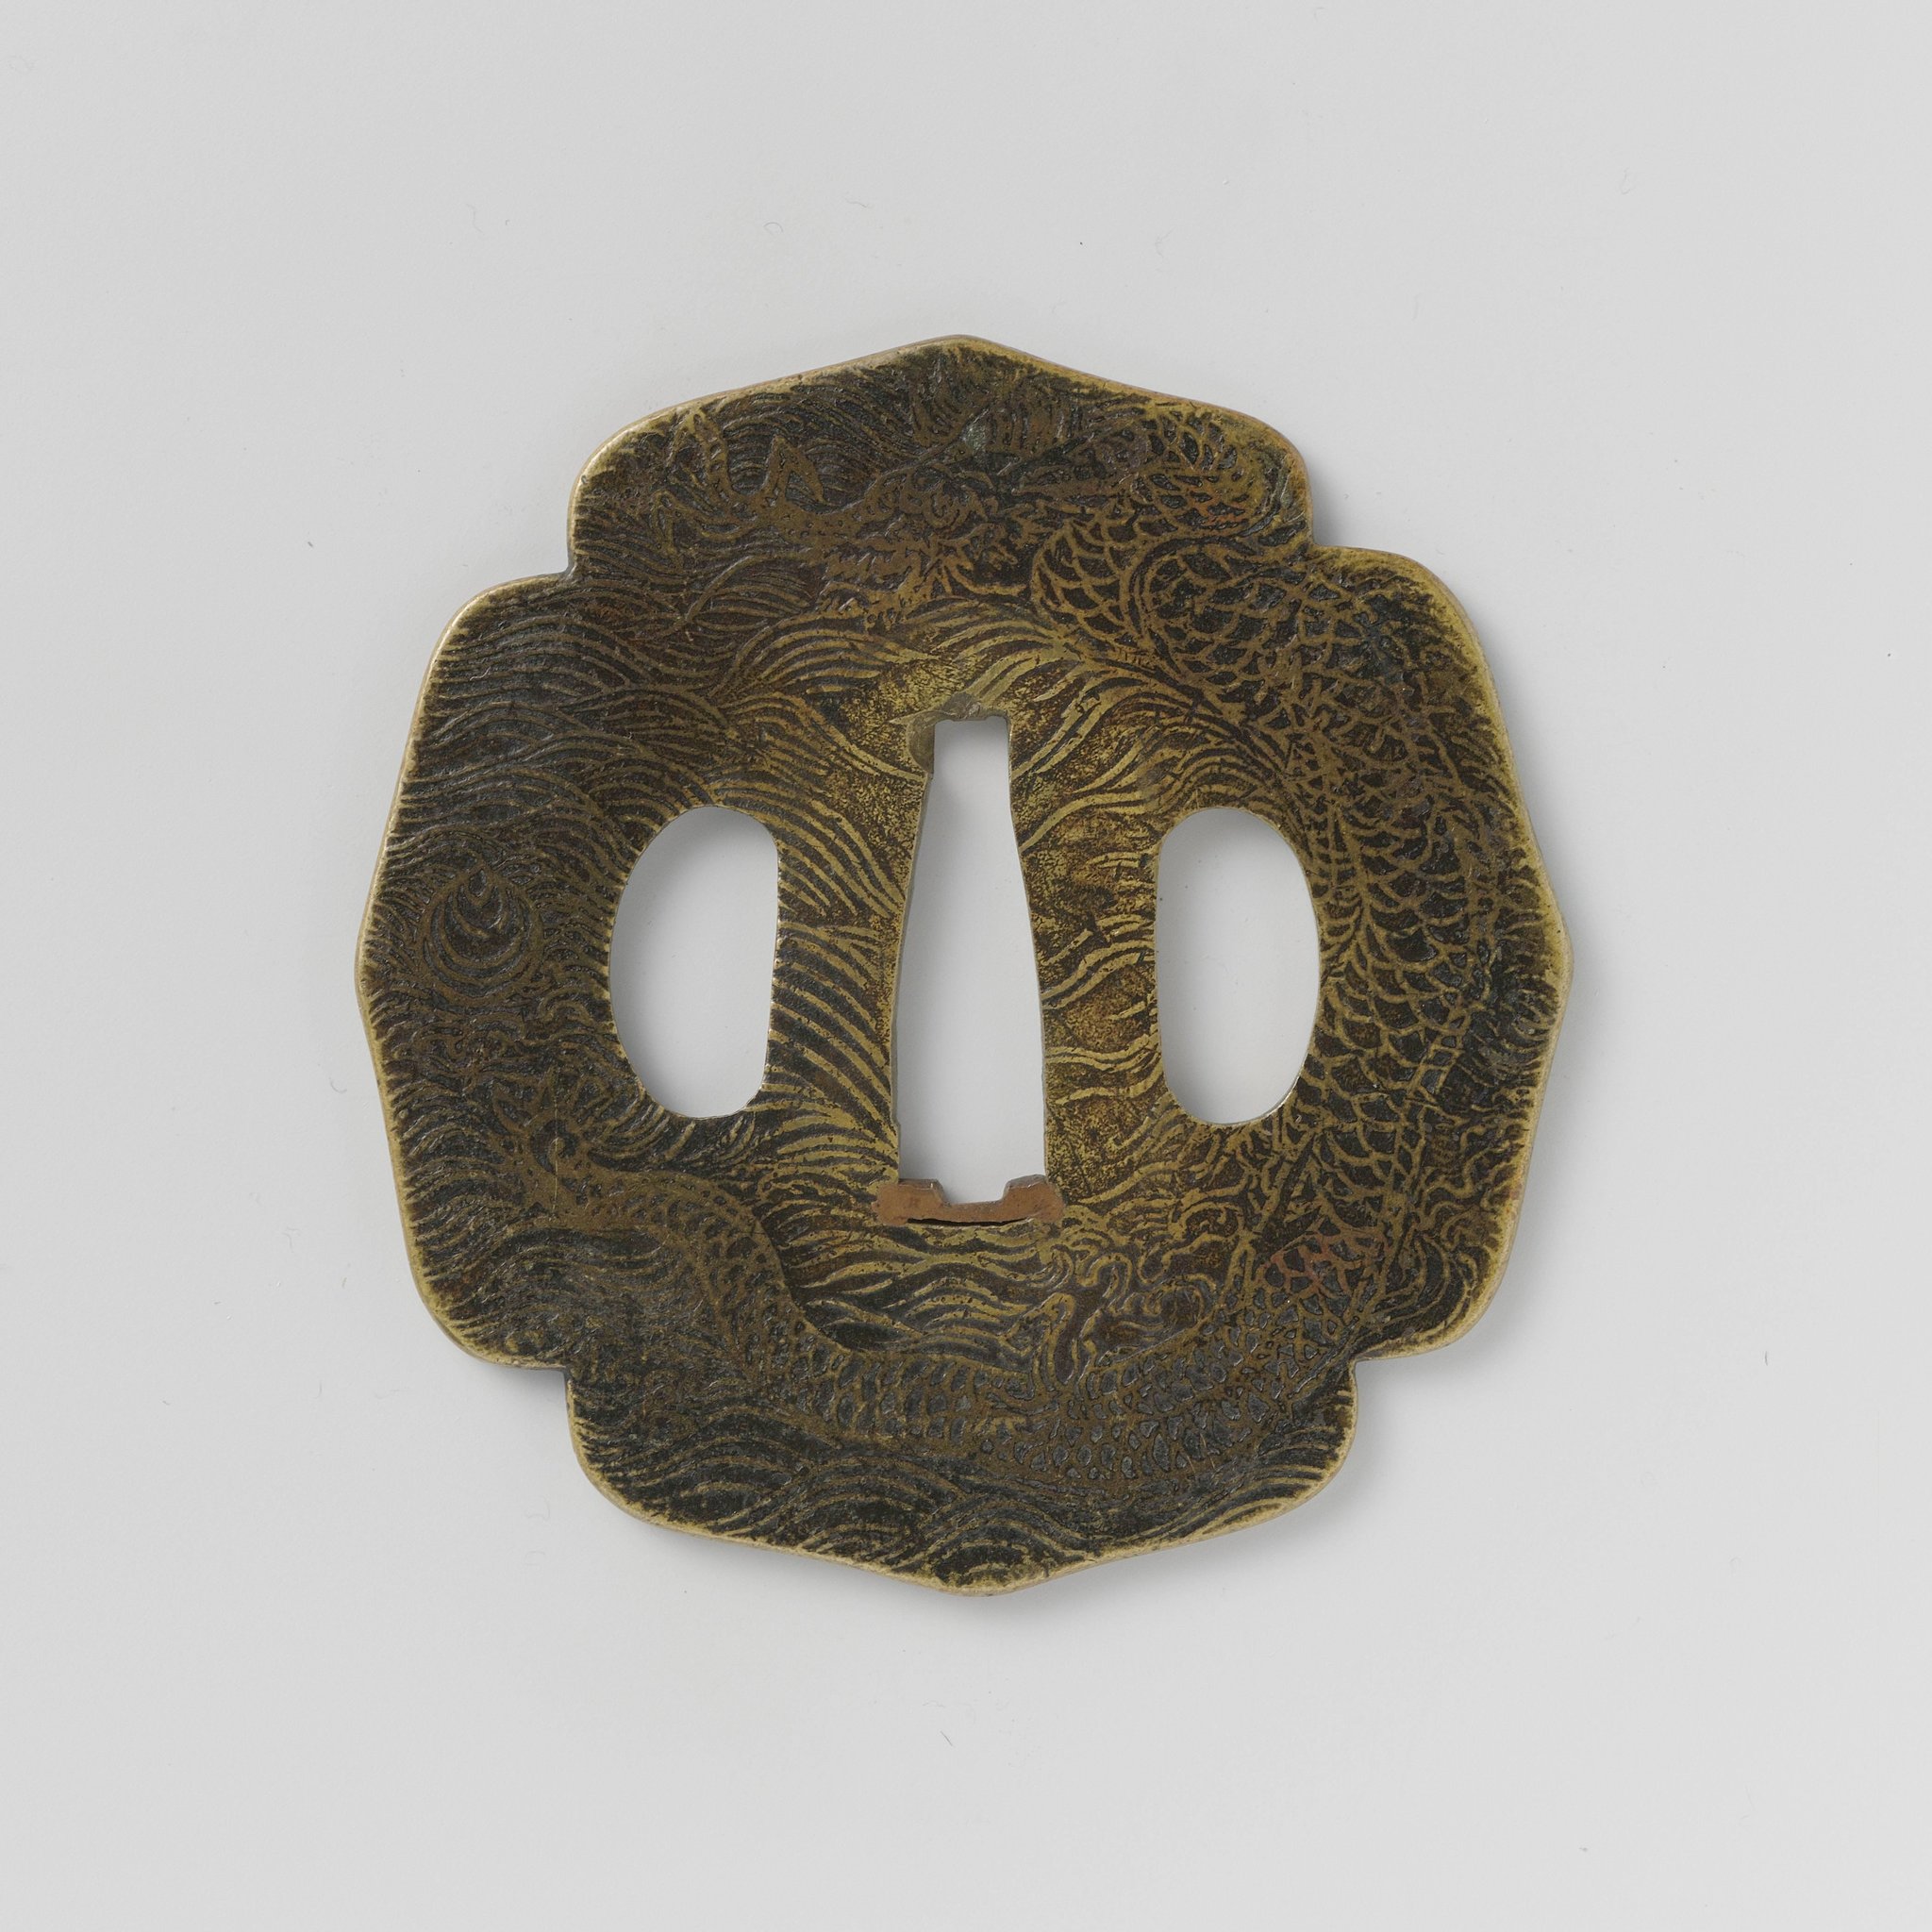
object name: tsuba, zwaardstootplaat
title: Hand guard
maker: Anonymous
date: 1600-1900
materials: copper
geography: japan